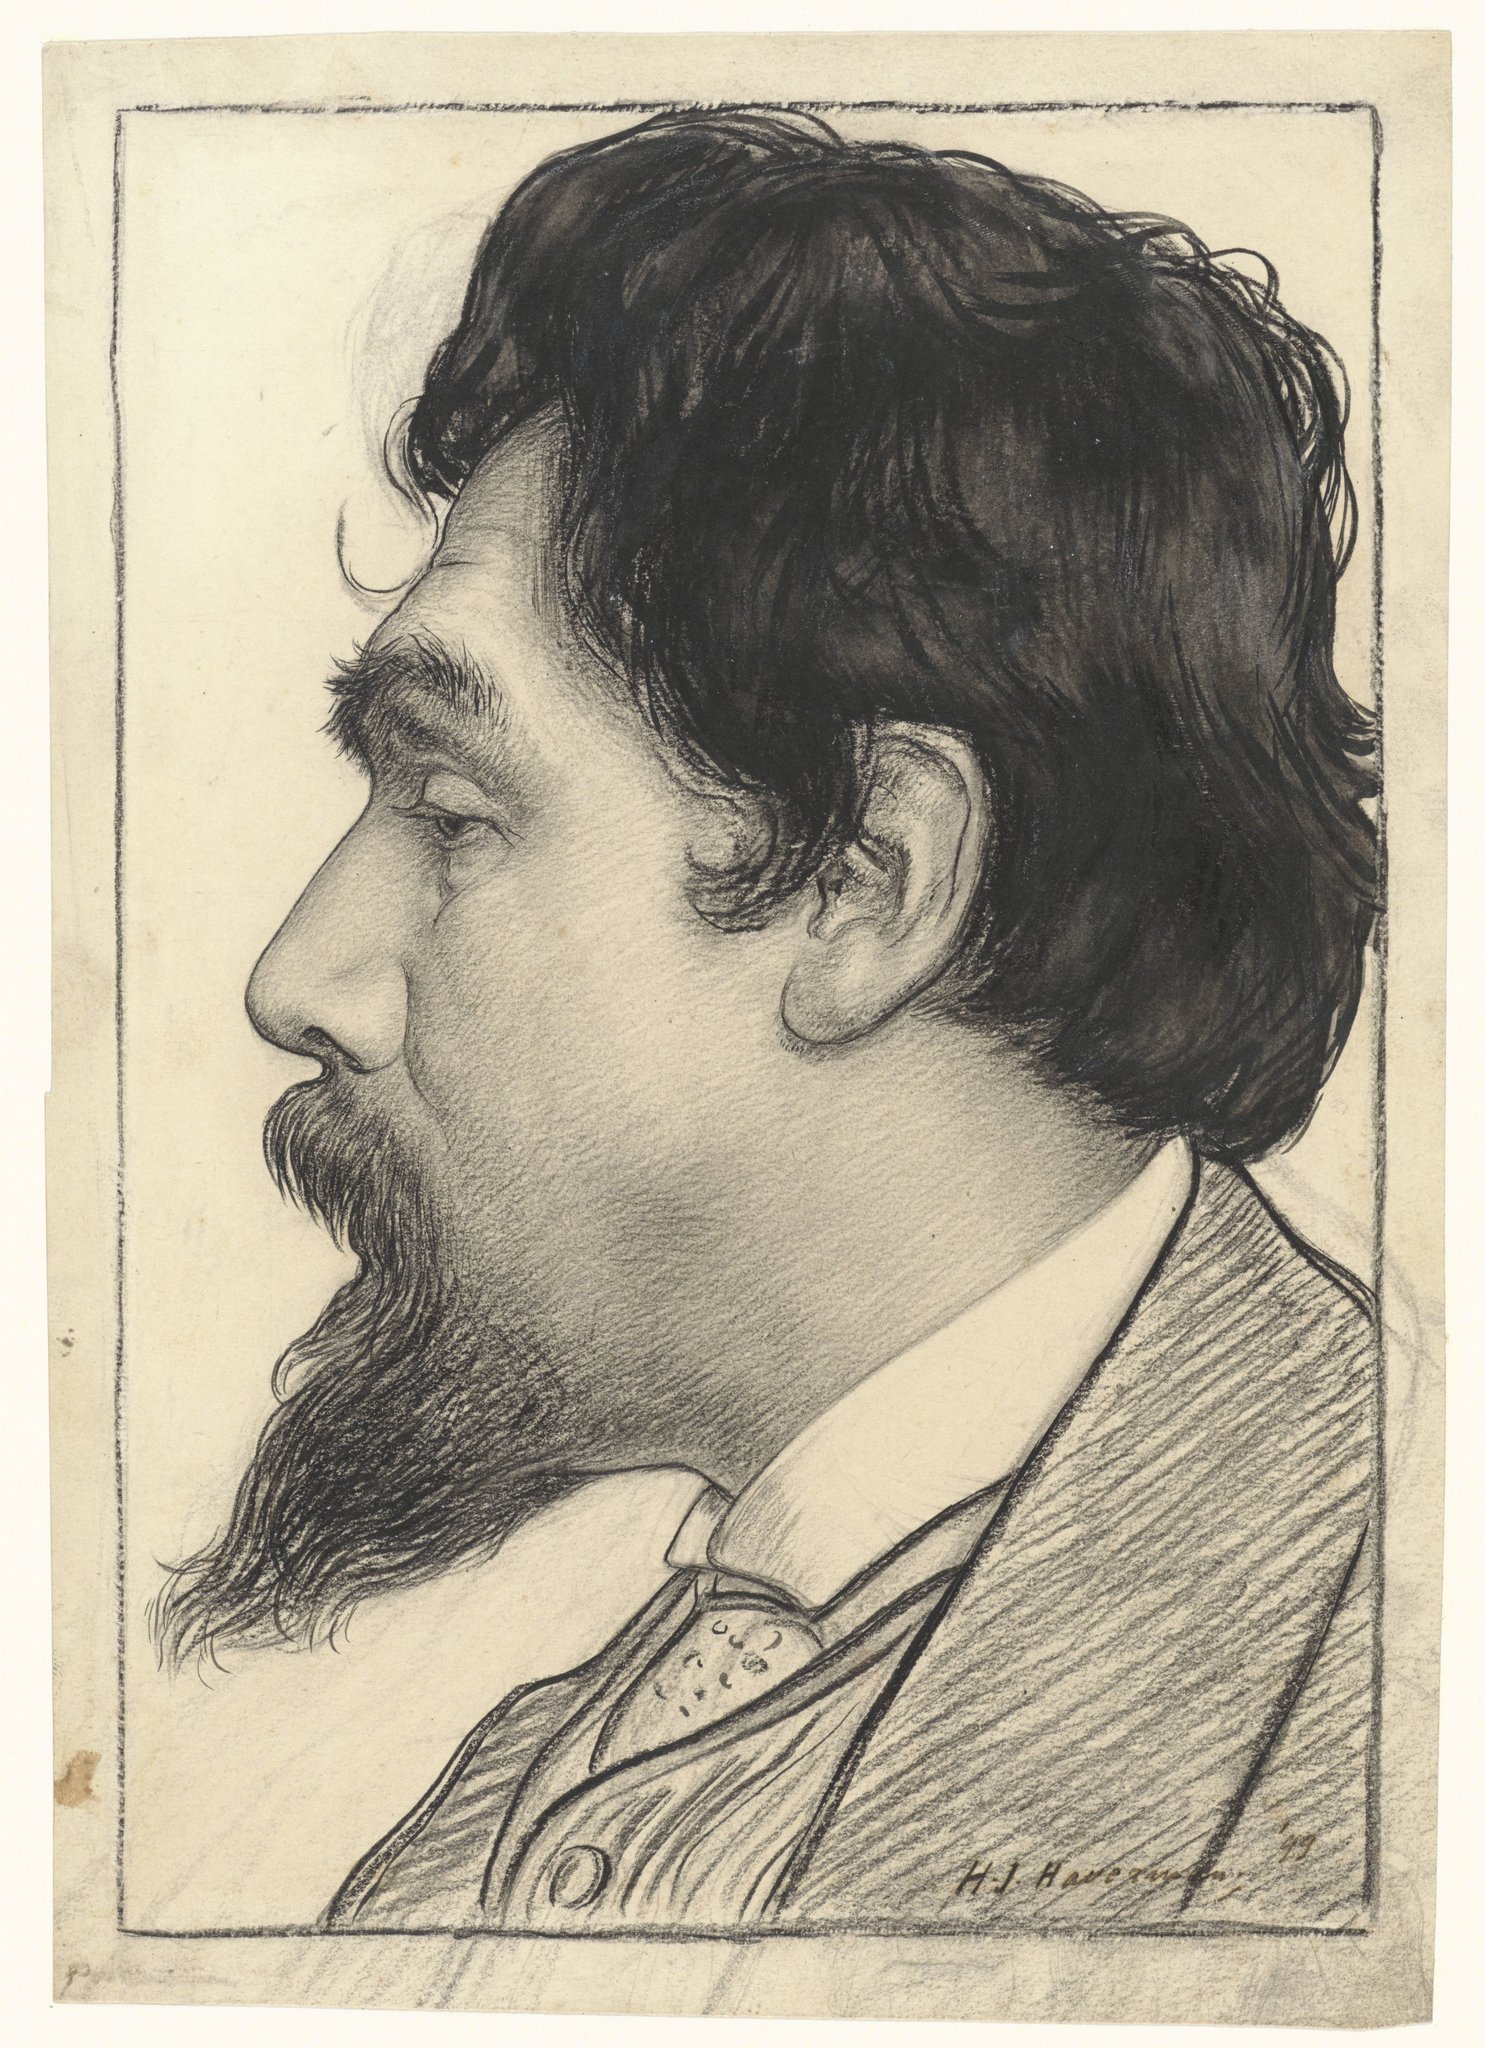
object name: drawing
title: Portret van Jan Toorop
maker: hendrik johannes haverman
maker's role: draughtsman, print maker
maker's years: 1857-1928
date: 1899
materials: chalk, paper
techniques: brush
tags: painter, jan toorop, historical persons, portrait, self-portrait of painter, portrait, self-portrait of artist